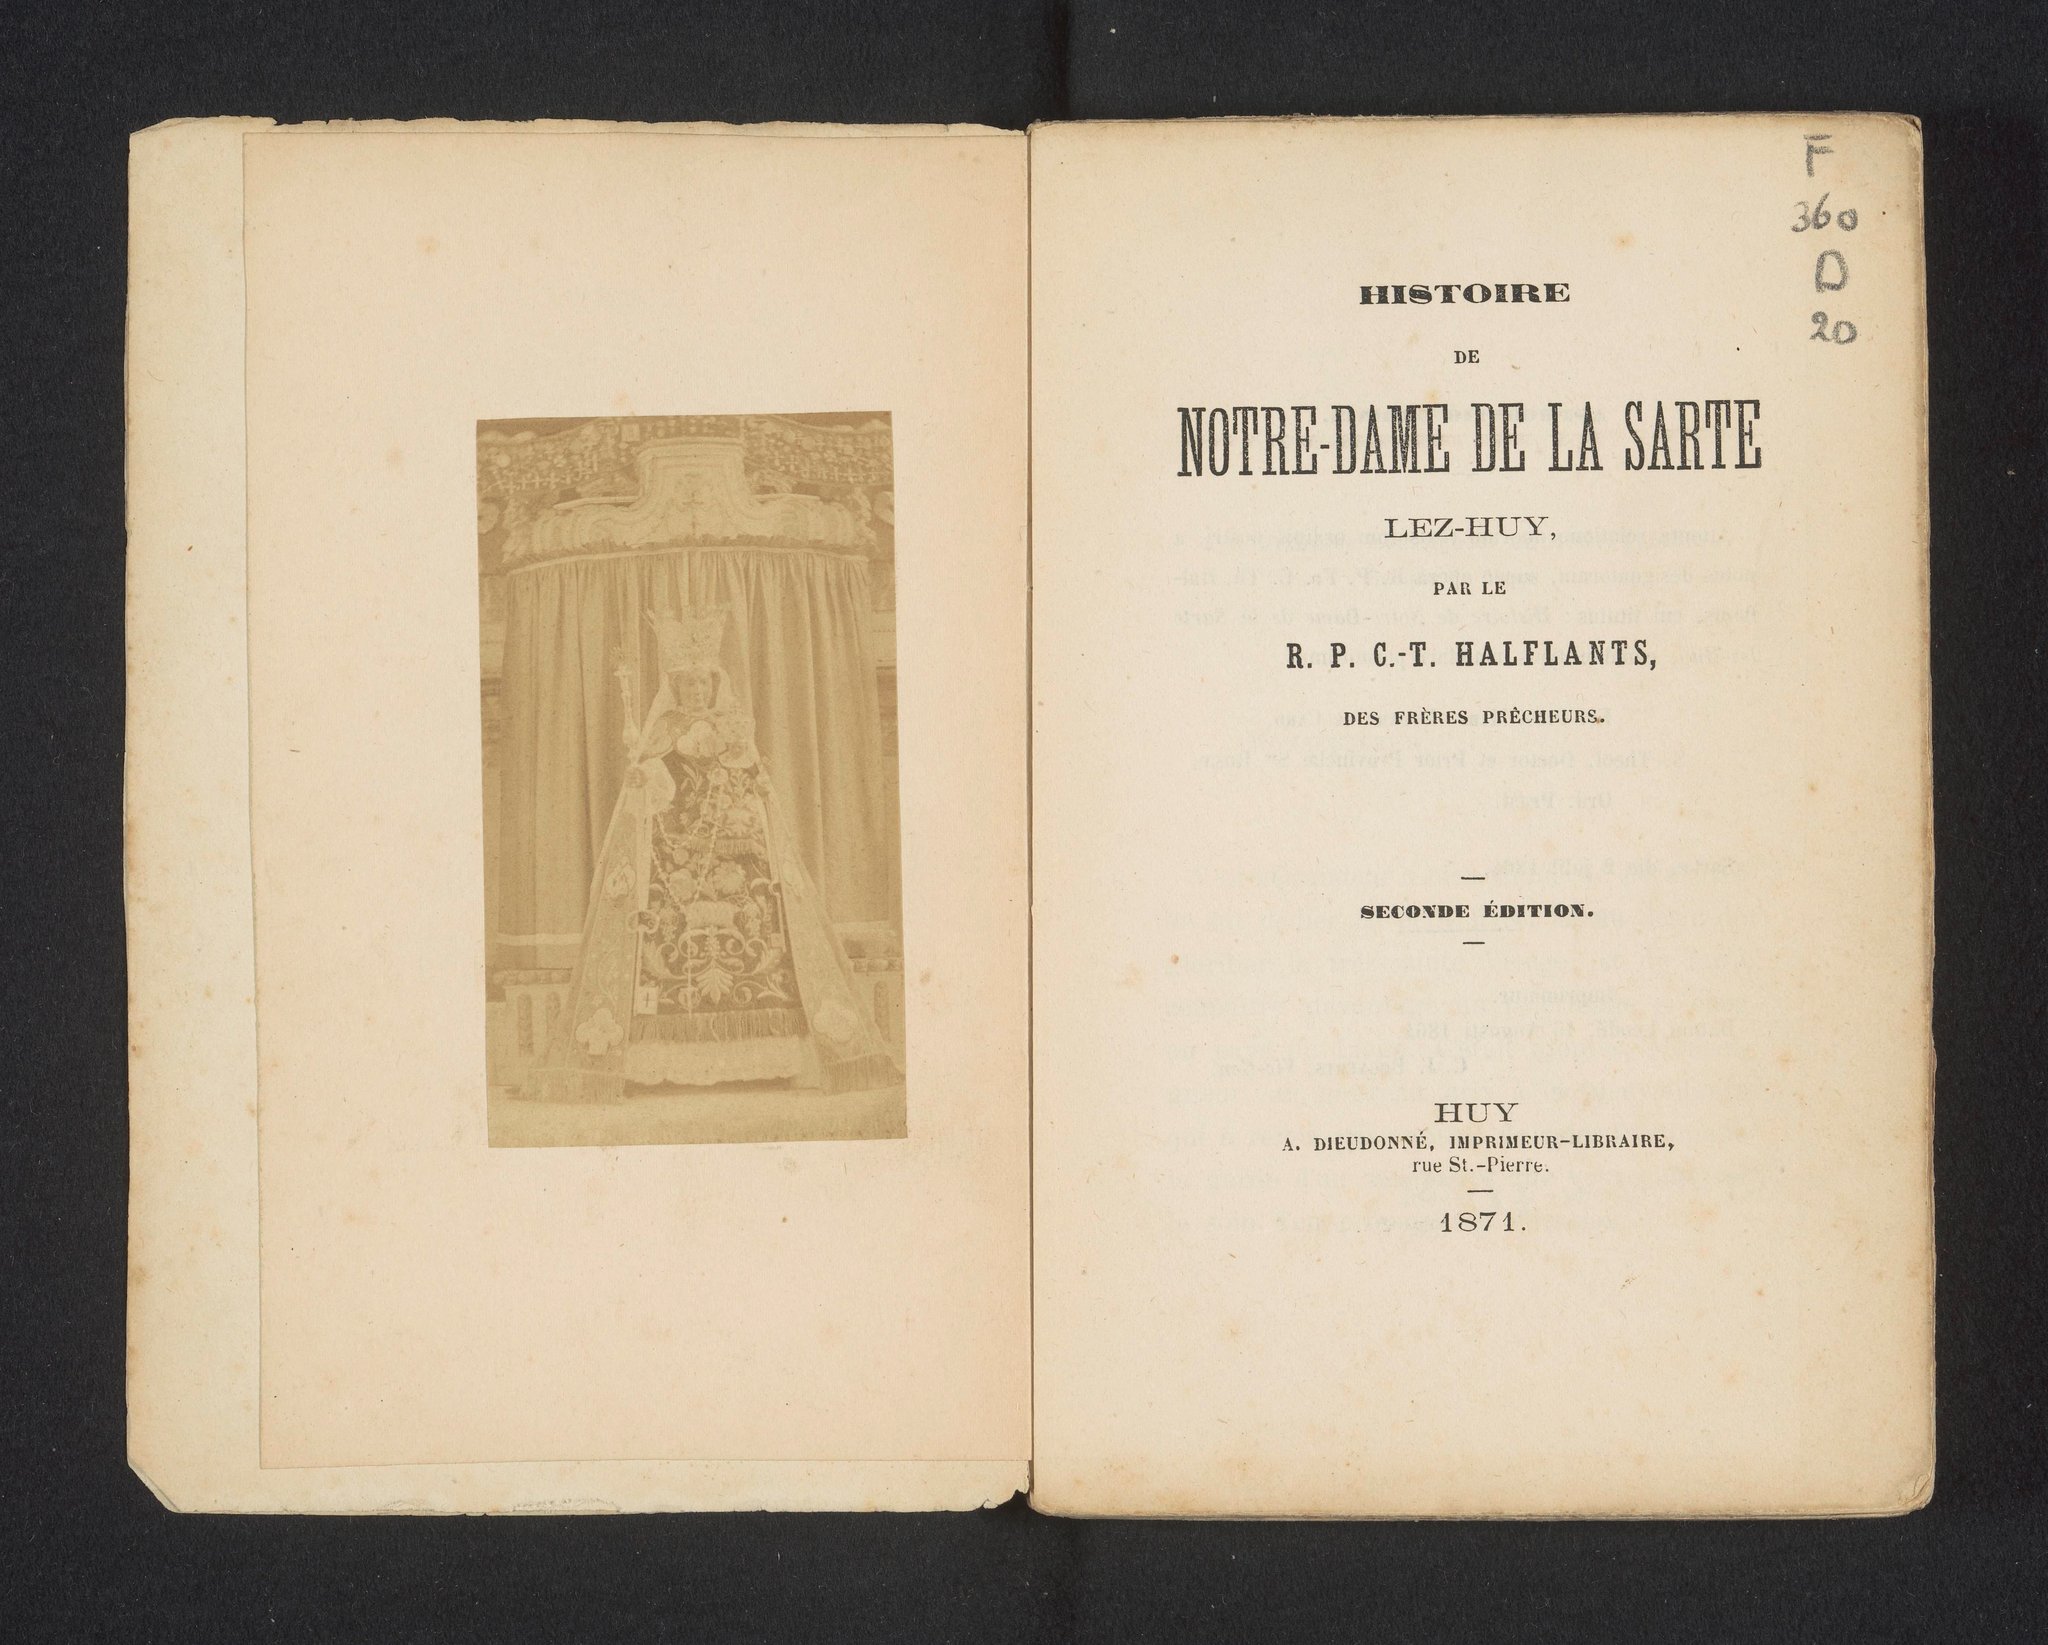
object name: book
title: Histoire de Notre-Dame de la Sarte lez-Huy / par C.-T. Halflants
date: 1871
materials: cardboard, paper, photographic support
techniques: albumen print, printing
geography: hoei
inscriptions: annotation: ‘NOV/ 1991’